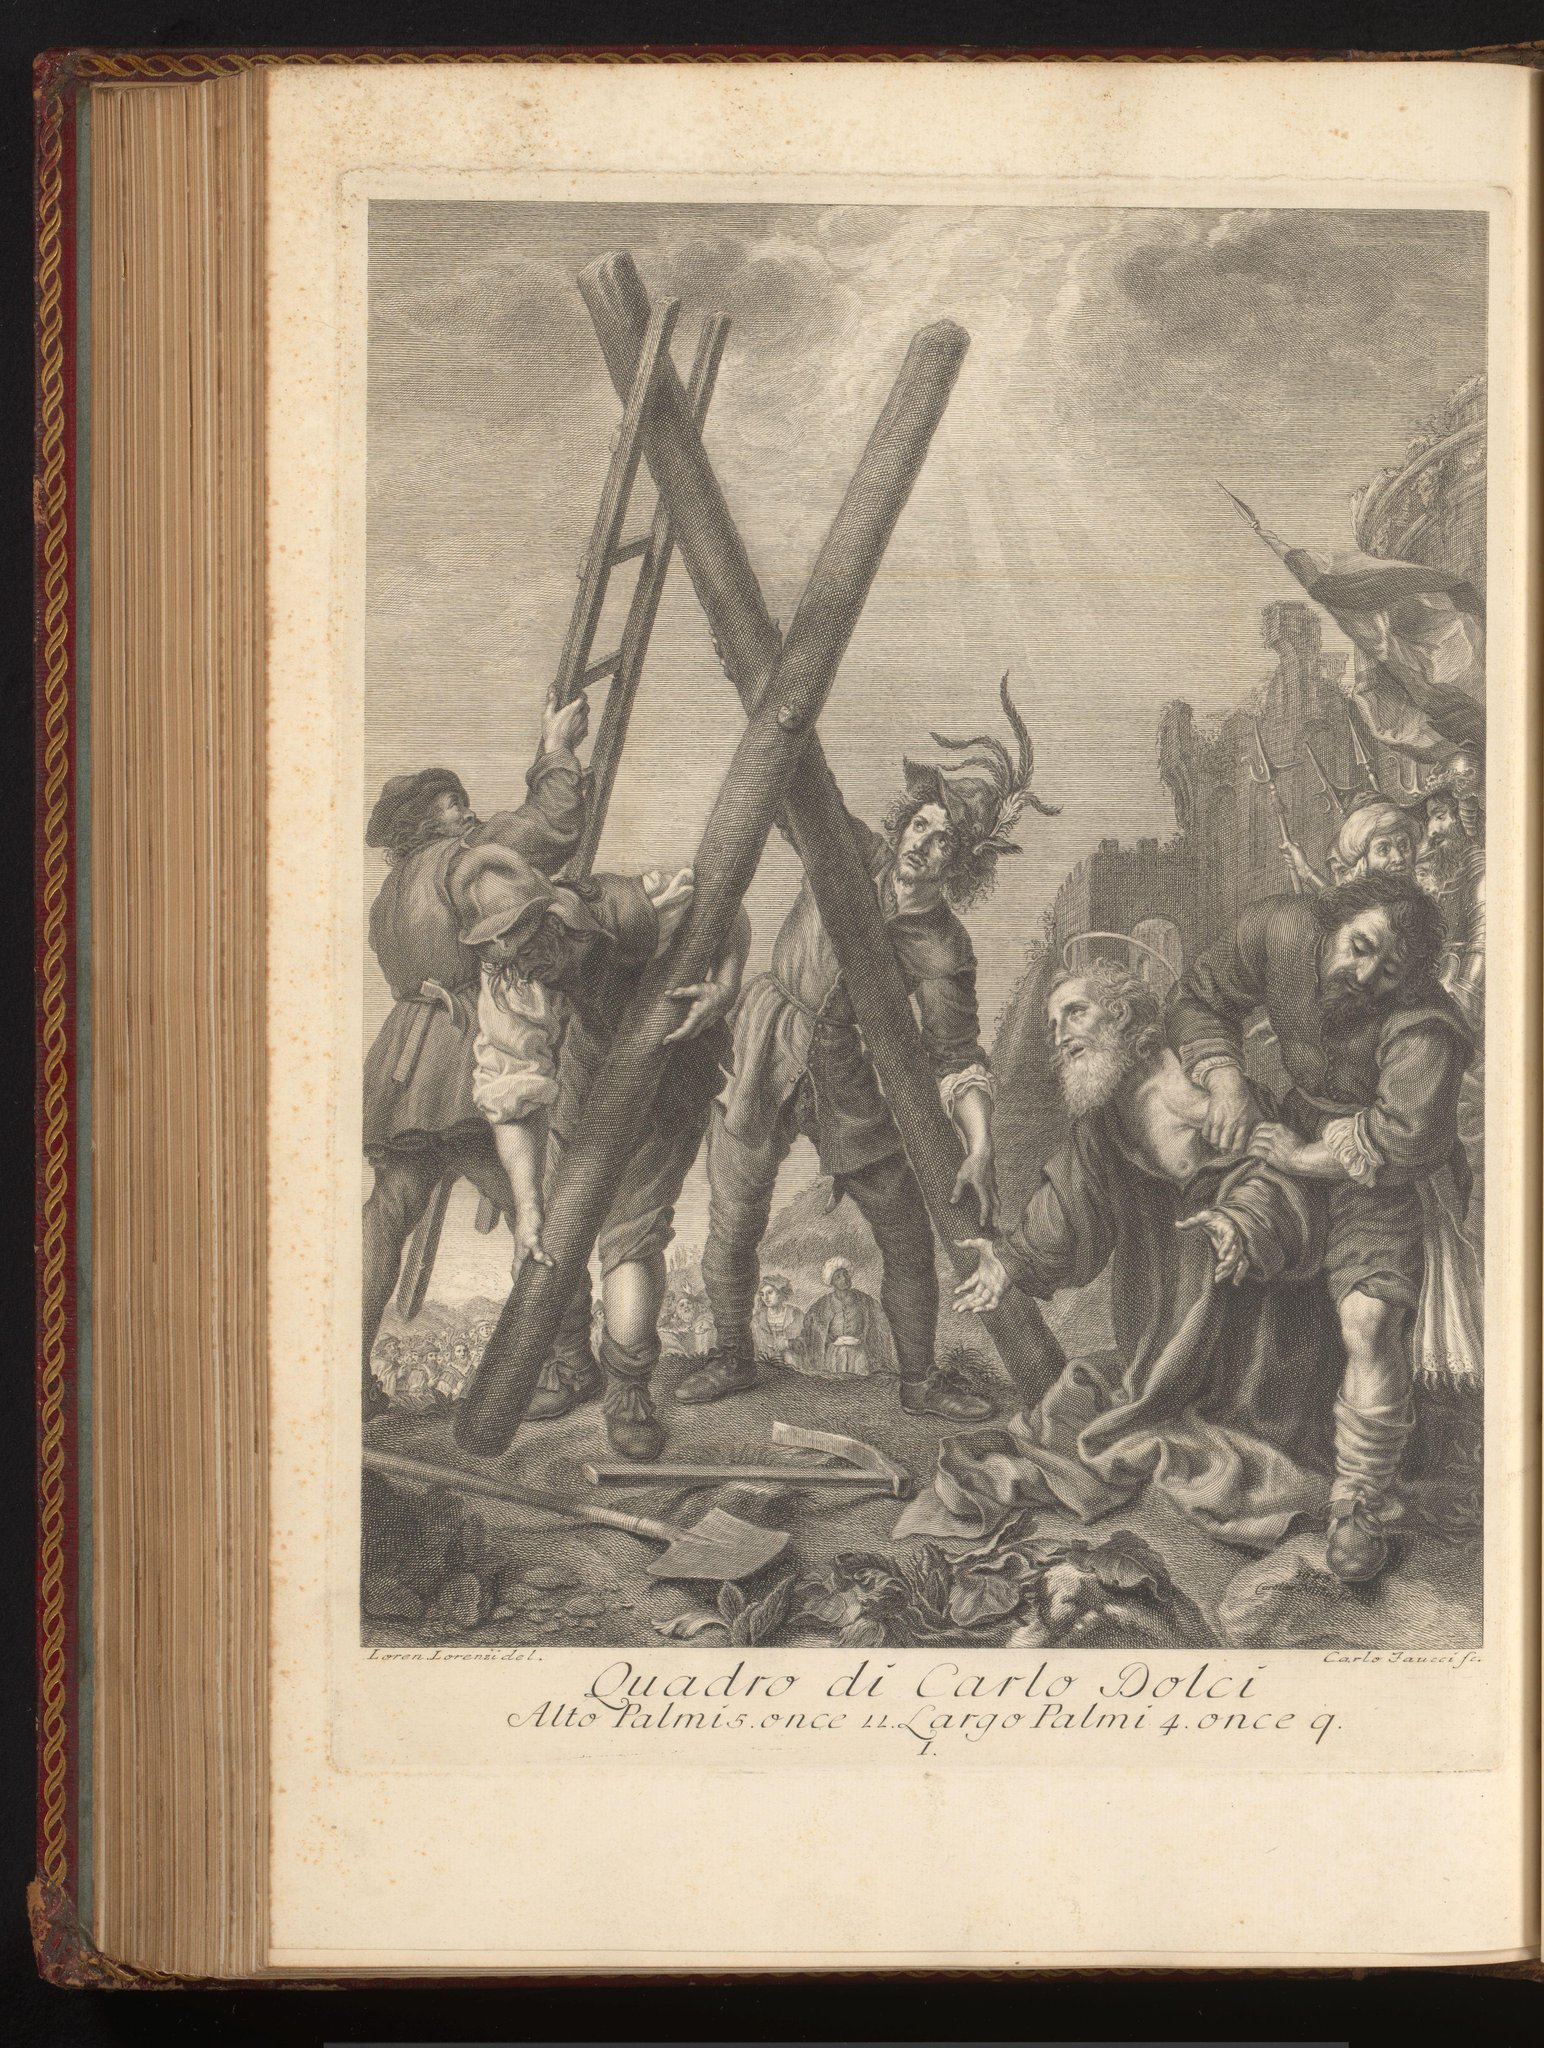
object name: print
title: Kruisiging van H. Andreas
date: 1646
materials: paper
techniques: engraving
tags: crucifixion of andrew: he is undressed and tied to the cross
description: De samensteller heeft deze prent in het album geplakt als illustratie bij: Pilkington, Matthew en Johann Heinrich Füssli. A dictionary of painters, from the revival of the art to the present period. 4 dln. Londen: John Crowder, 1805, dl. 1, p. 159. Een latere staat van deze prent, zonder omlijning, is ook gebruikt in: Raccolta di 80 stampe rappresentanti i quadri più scelti de Sig.ri March.si Gerini di Firenze. 2 dln. S.l.s.n., 1786, dl. 1.